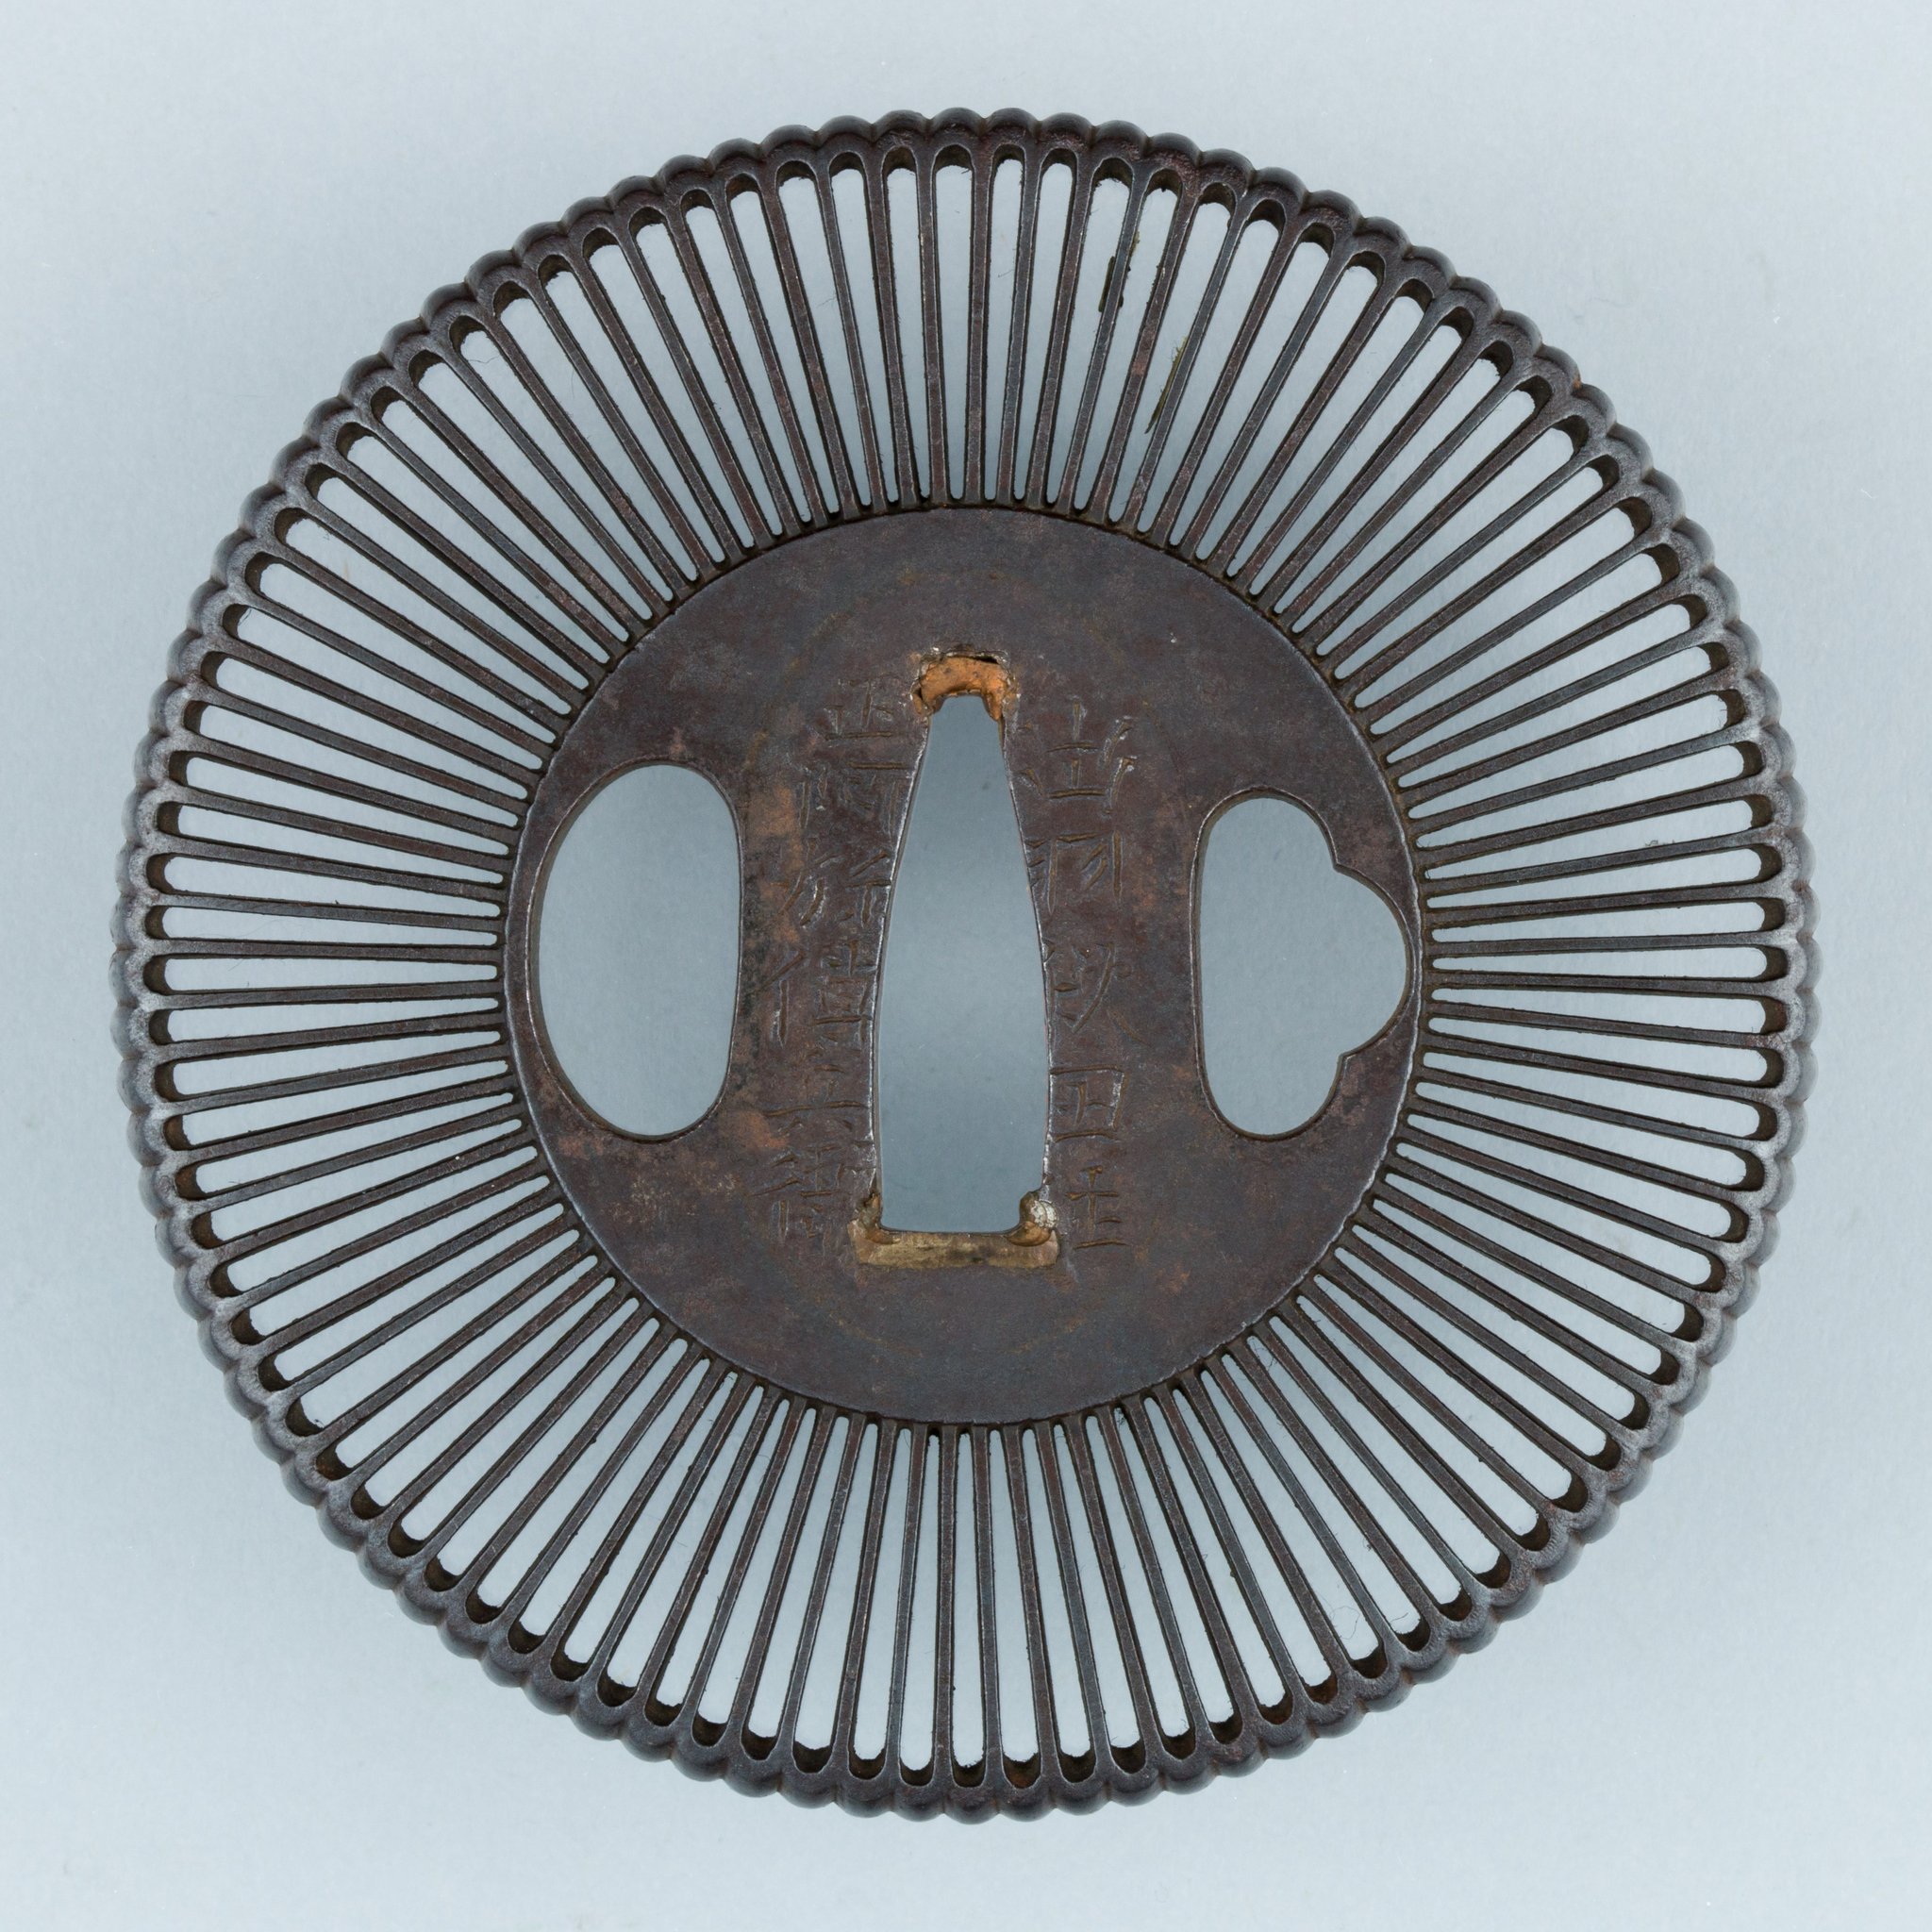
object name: sword guard tsuba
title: Sword Guard (Tsuba)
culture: japanese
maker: shōami denbei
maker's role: fittings maker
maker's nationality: japanese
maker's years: 1650-1750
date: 1667-1733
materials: copper, iron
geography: japan